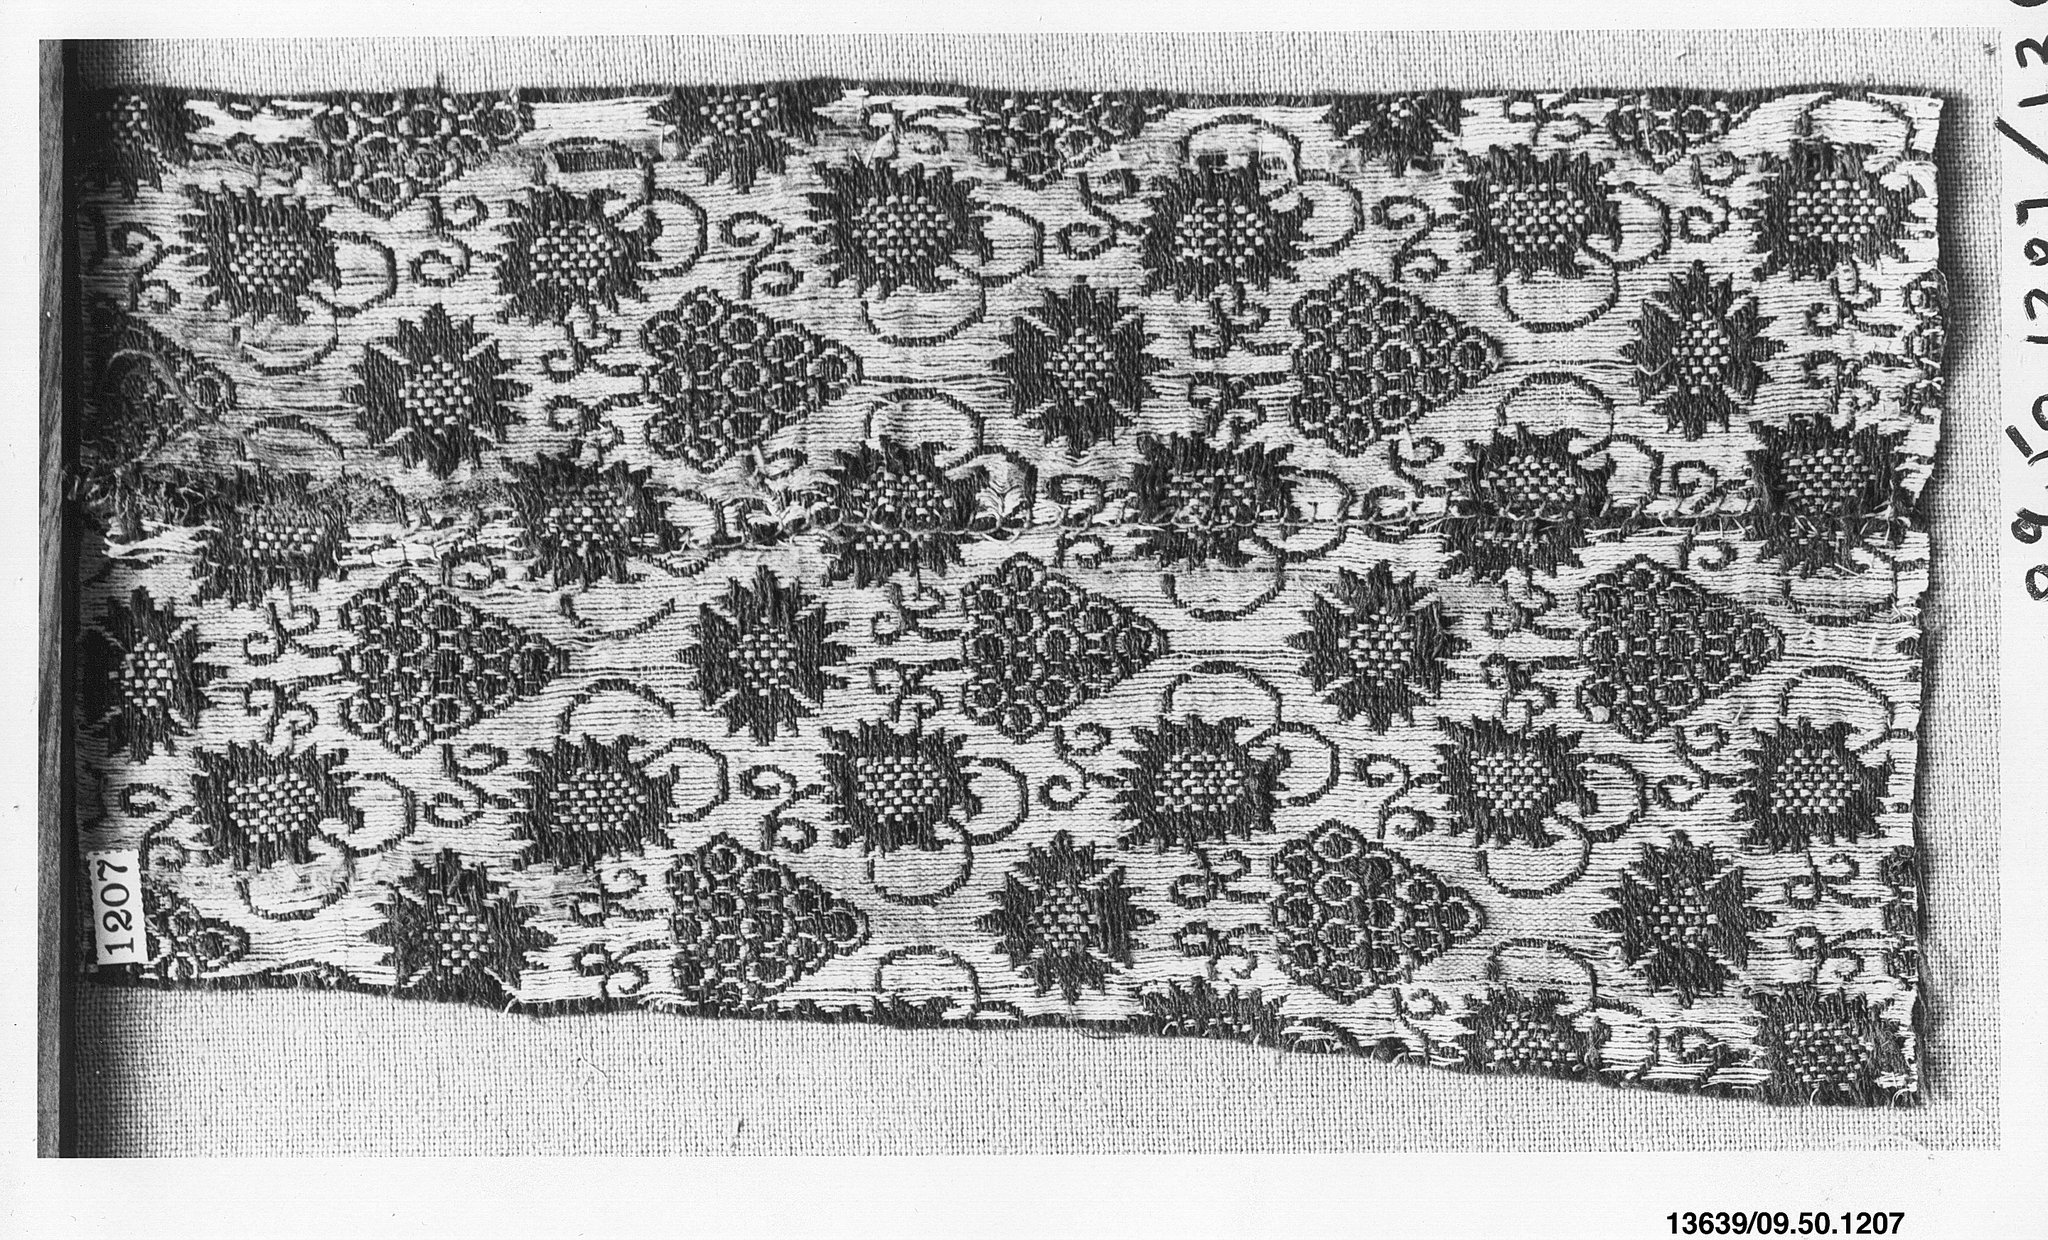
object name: piece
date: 1501-1600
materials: silk